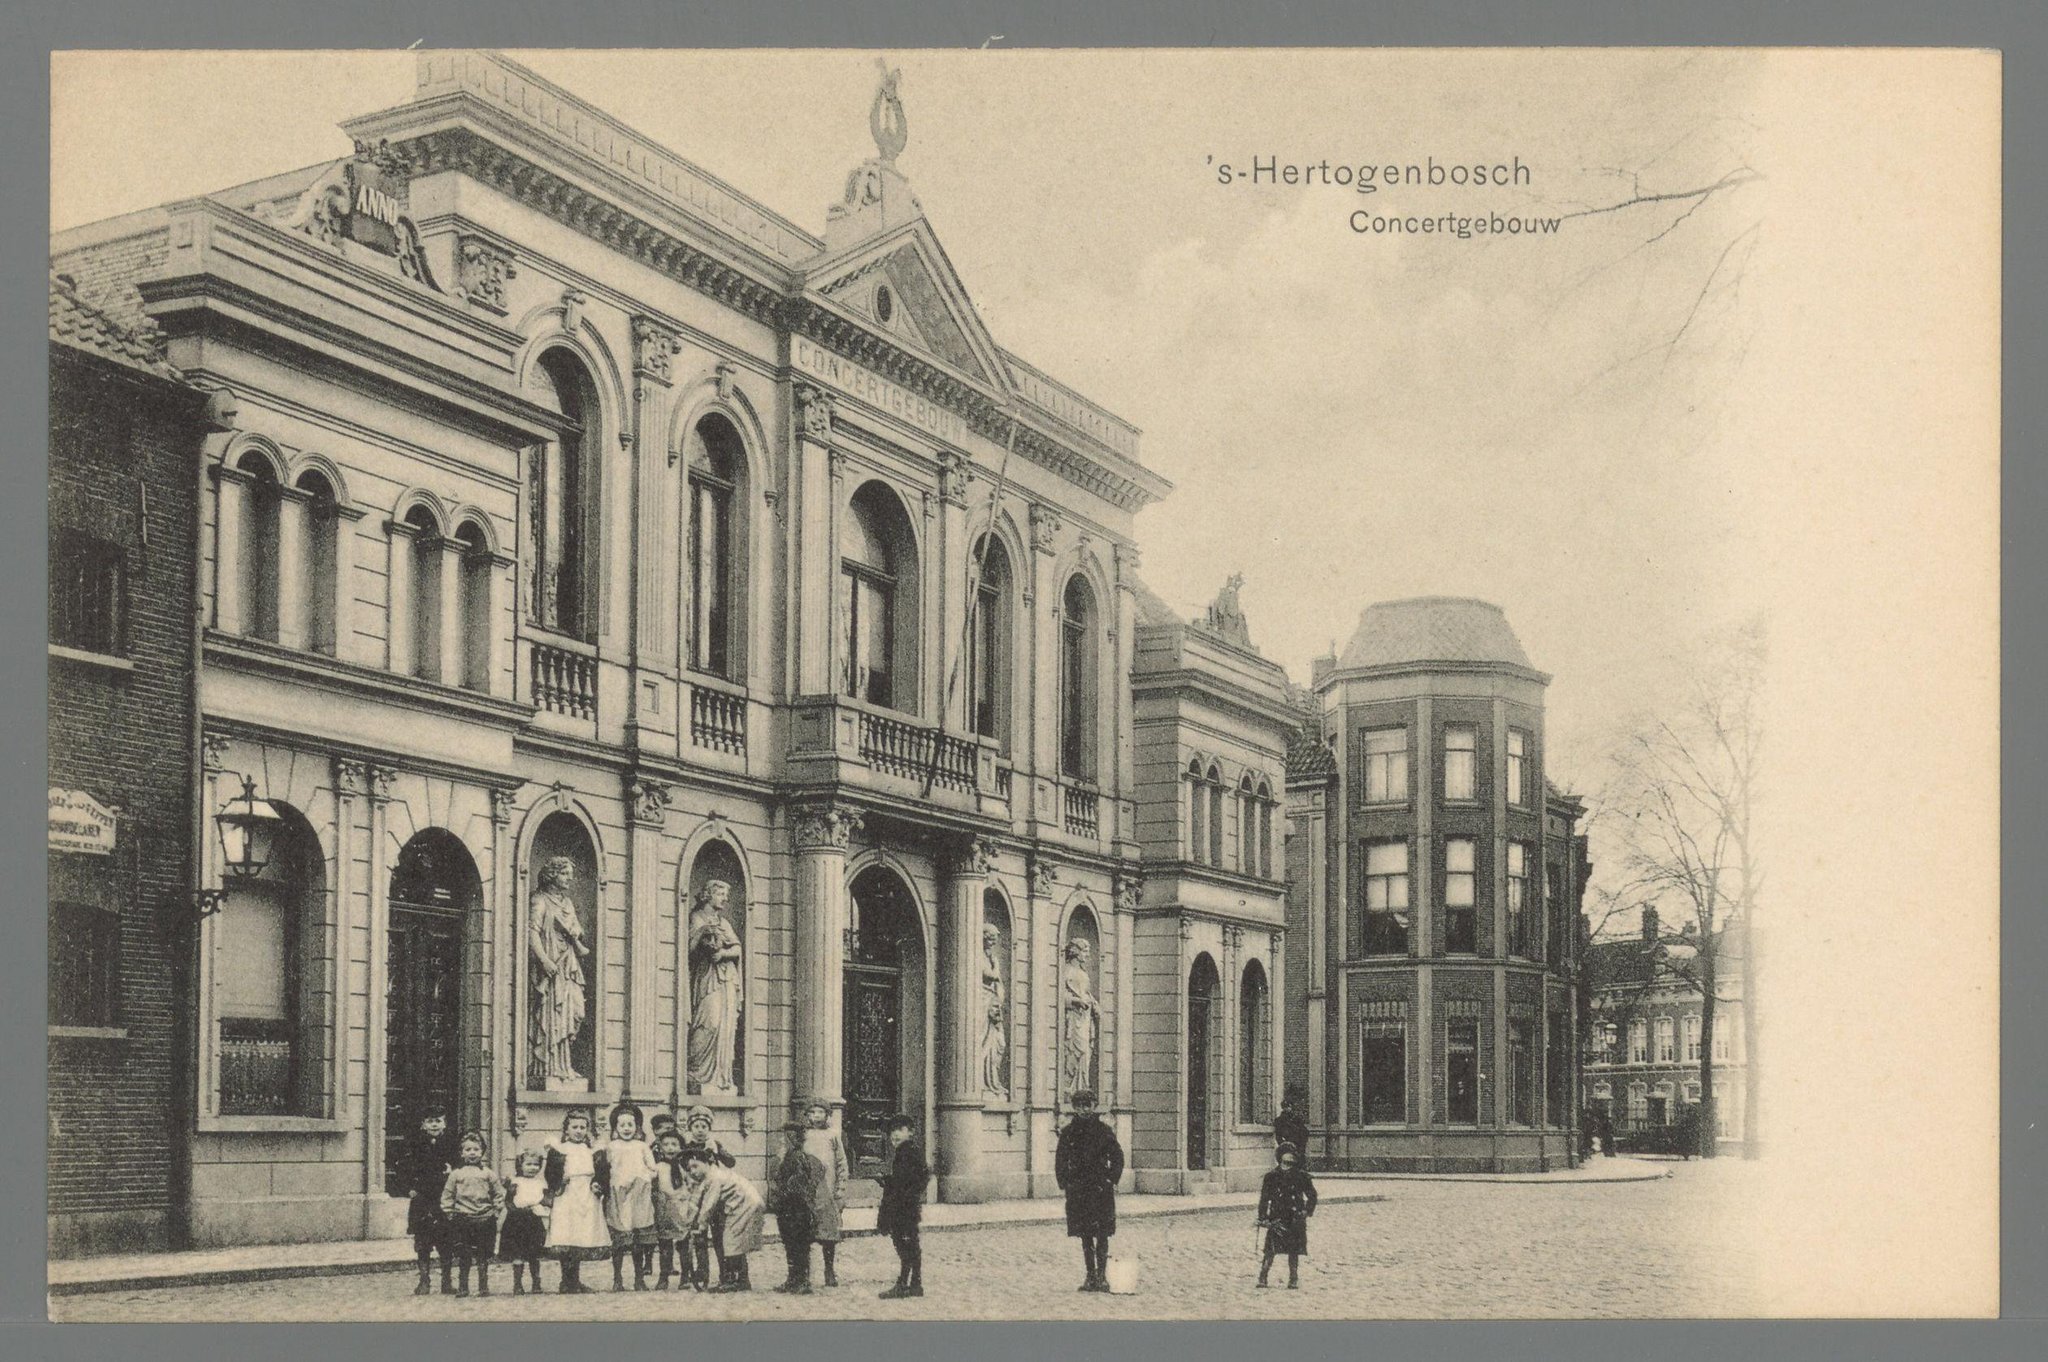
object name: photomechanical print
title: 's-Hertogenbosch. Concertgebouw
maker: Anonymous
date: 1905-1910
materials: cardboard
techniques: photograph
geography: den bosch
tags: concert hall, den bosch